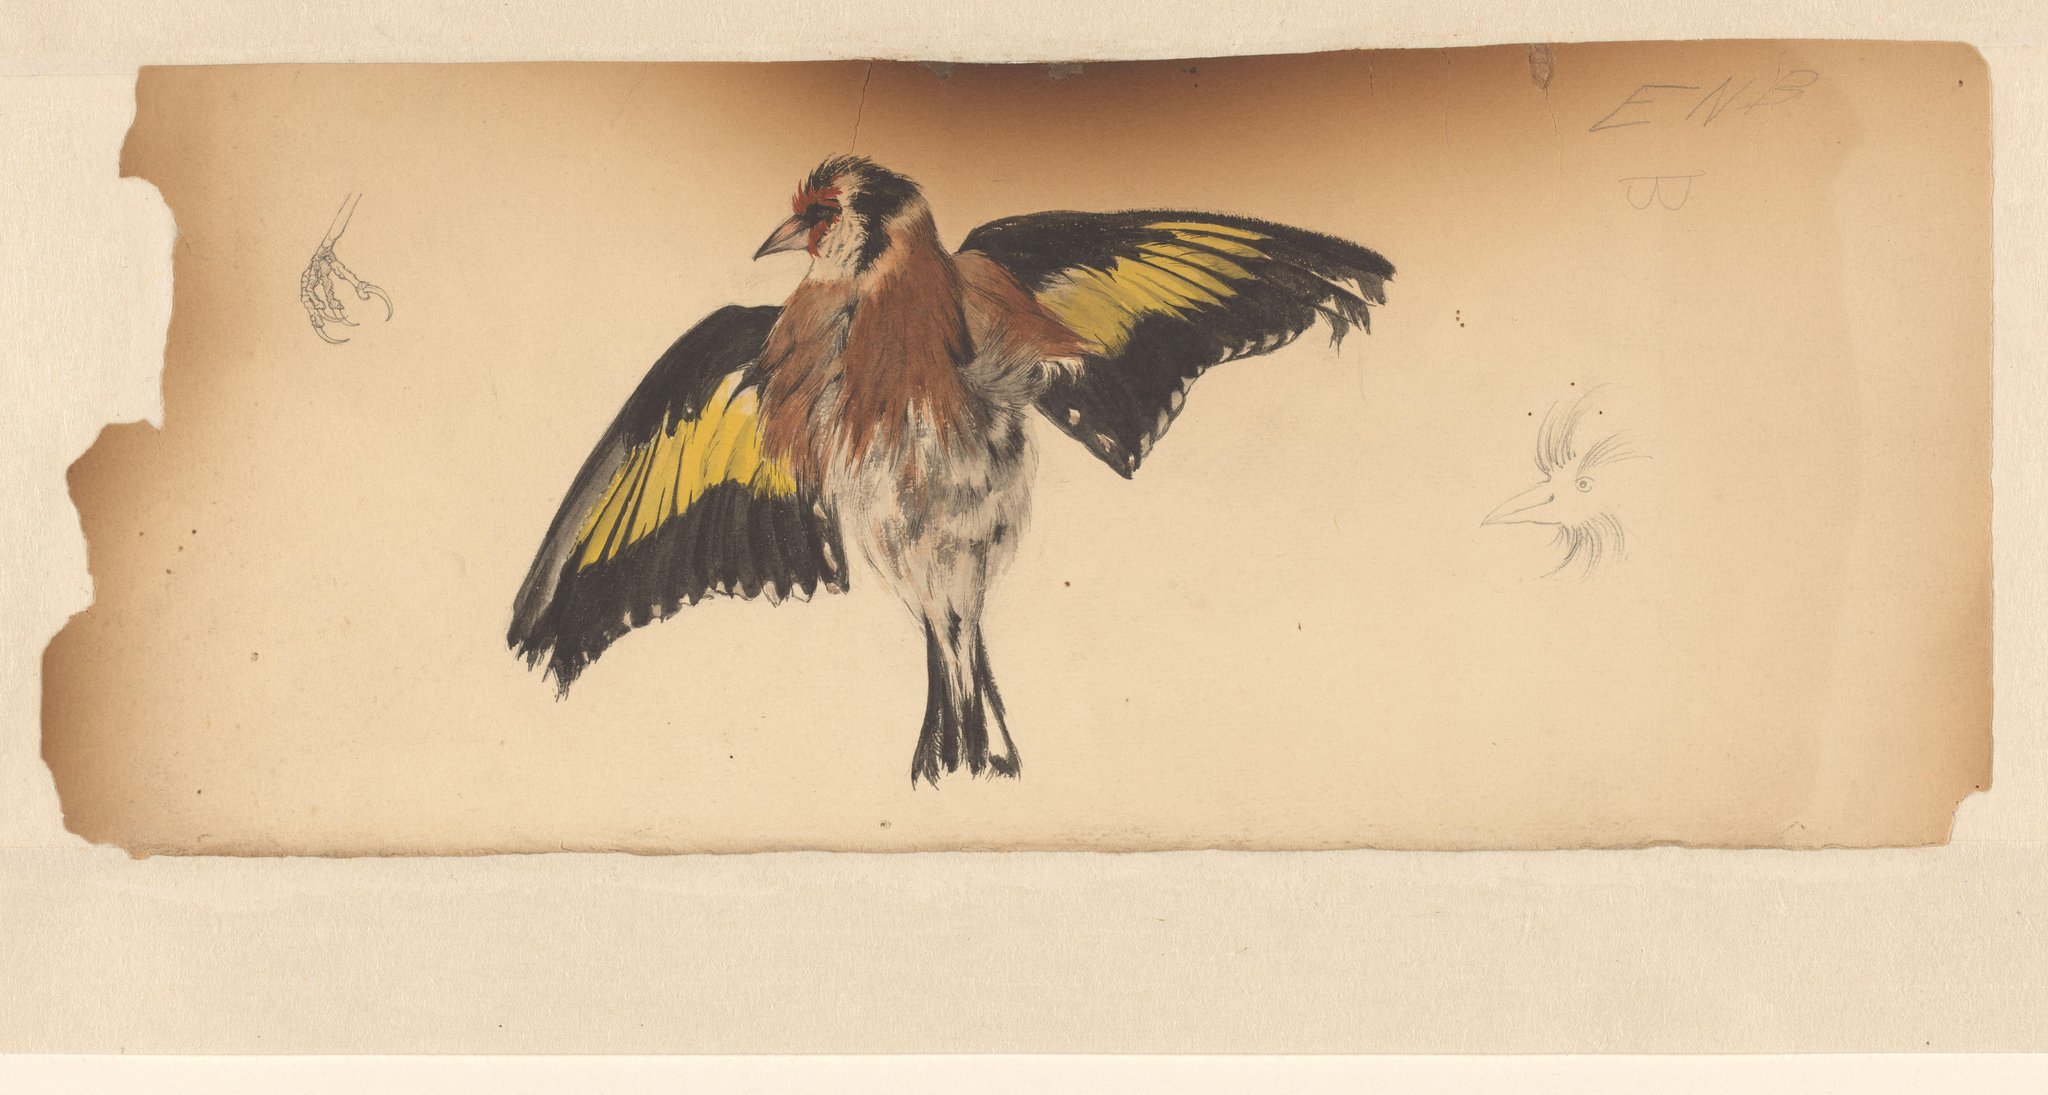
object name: drawing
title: Vogel met uitgespreide vleugels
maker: julie de graag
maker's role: draughtsman, print maker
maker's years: 1877-1924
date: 1887-1924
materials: ink, paper, pencil, watercolor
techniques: brush, pen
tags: birds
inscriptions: inscription: ‘RP.’, inscription: ‘ENB’, number: ‘165’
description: Tevens studies van de poten en kop van een vogel.